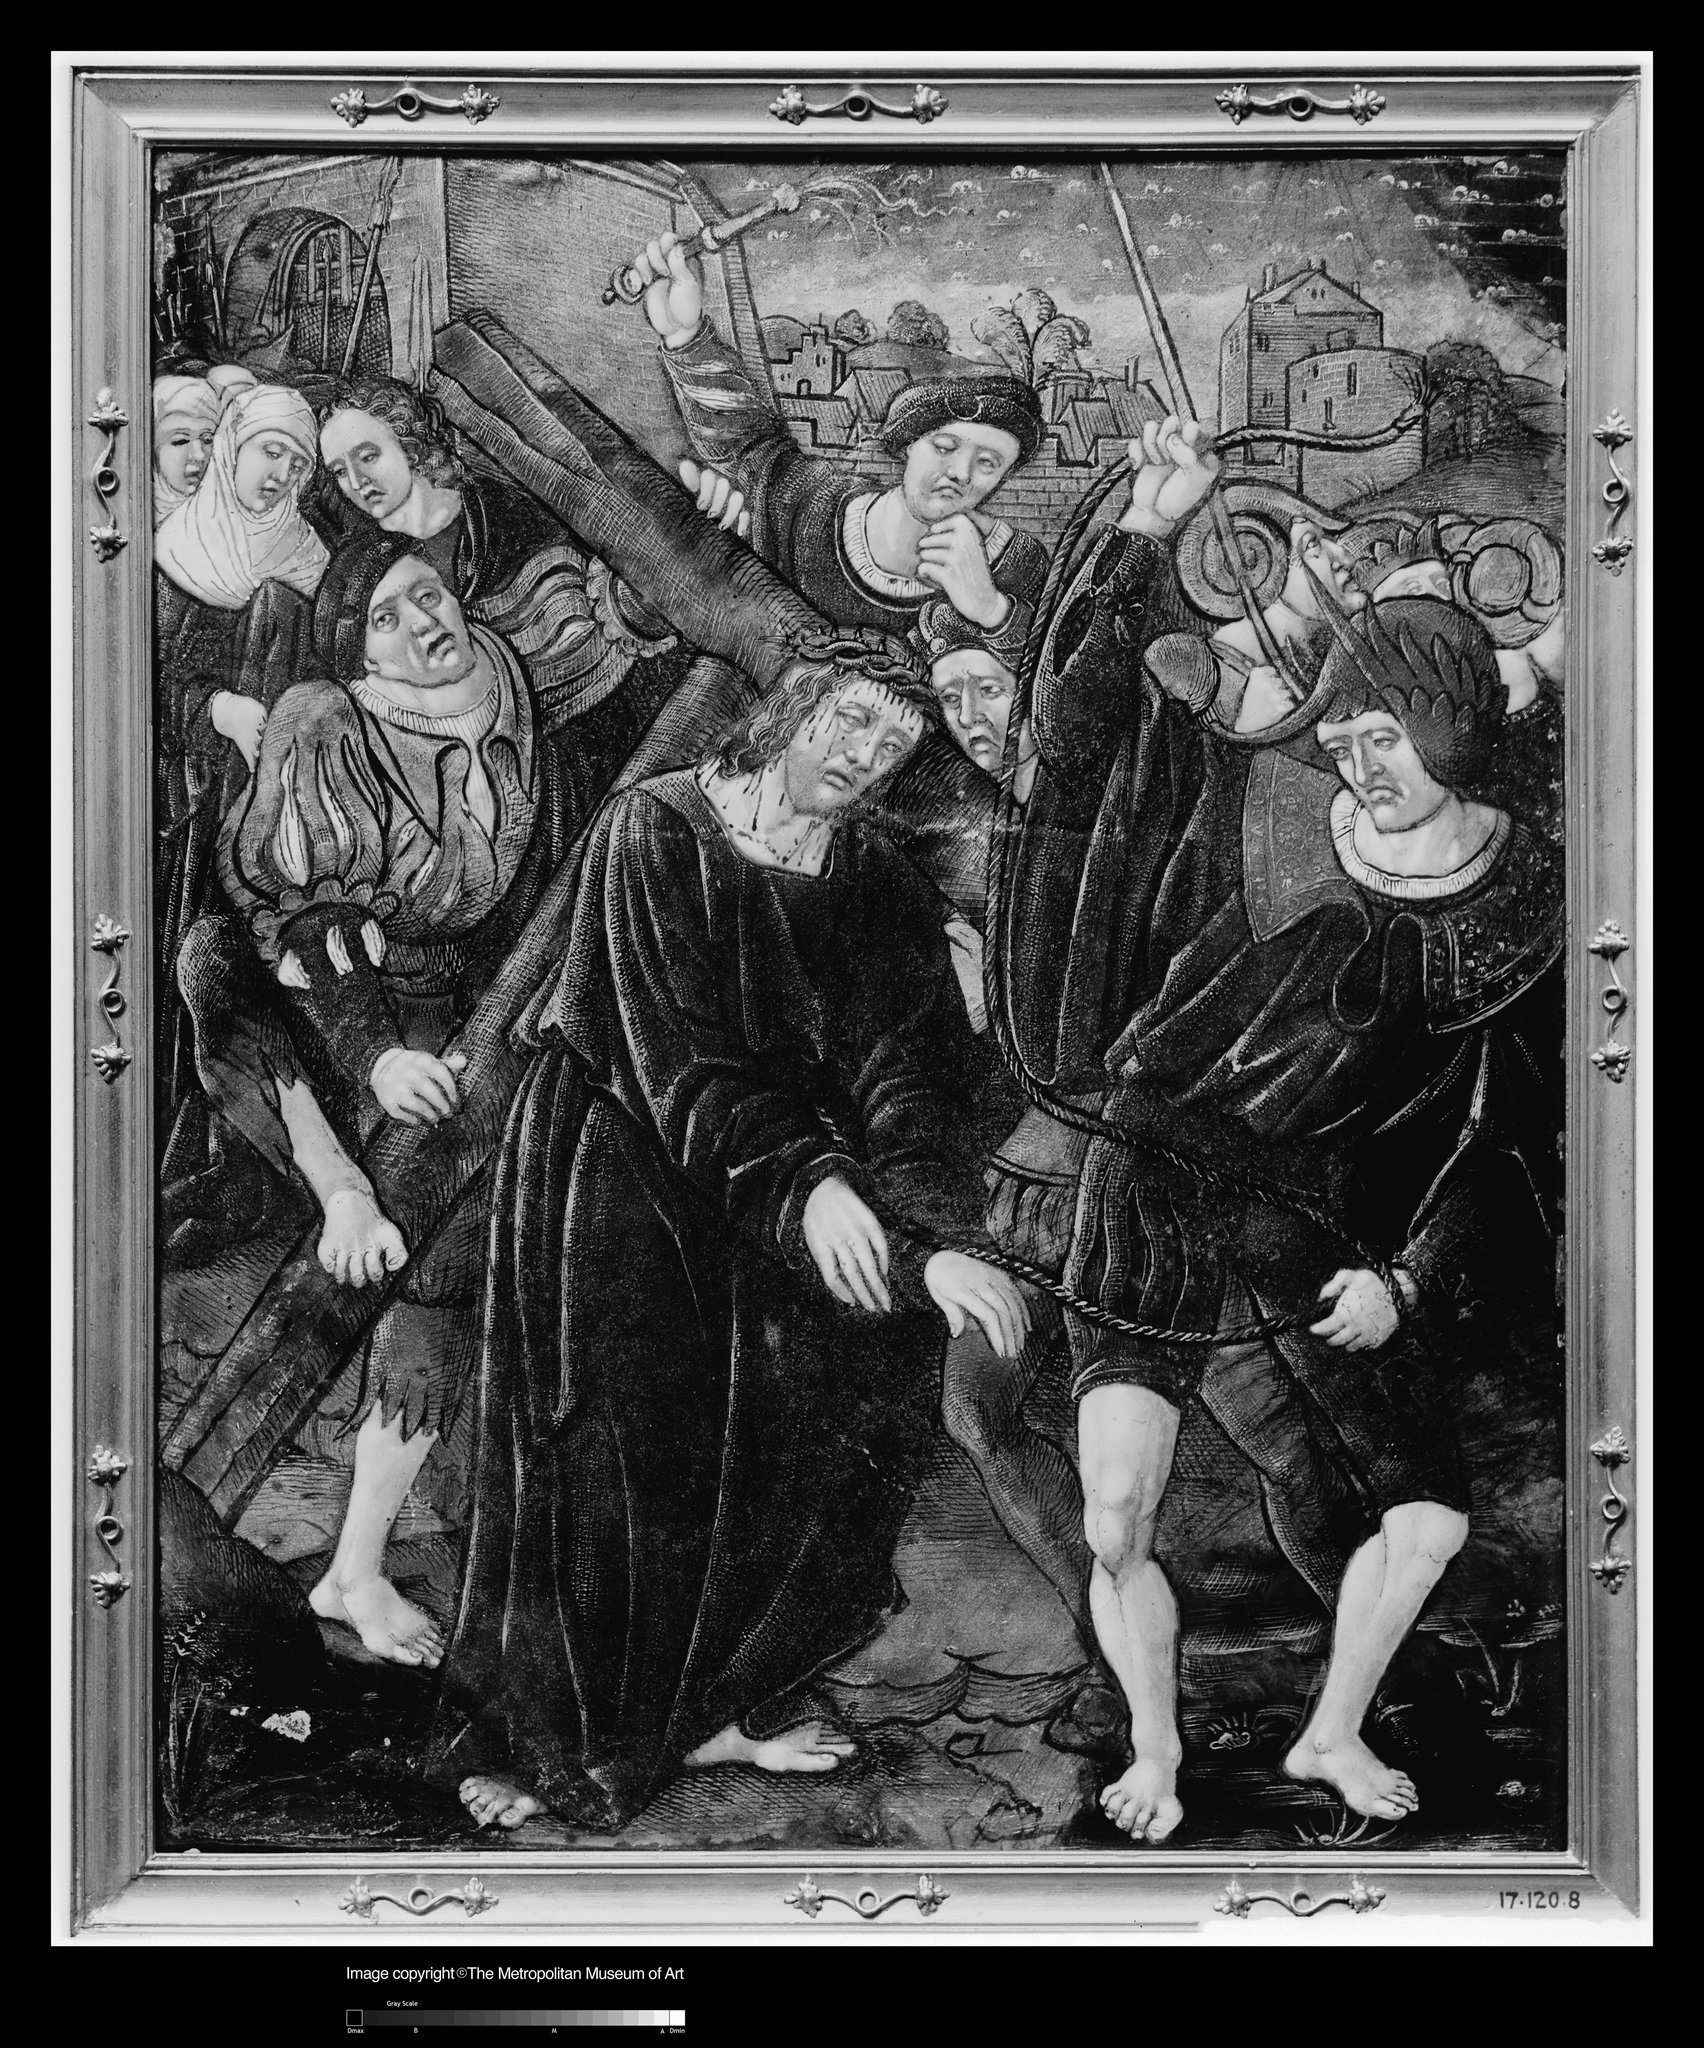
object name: plaque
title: Christ Bearing the Cross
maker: jean pénicaud i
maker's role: enameler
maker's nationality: french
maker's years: 1490-1543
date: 1501-1533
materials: copper, enamel, gilt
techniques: painting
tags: men,women,christ,cross,jesus